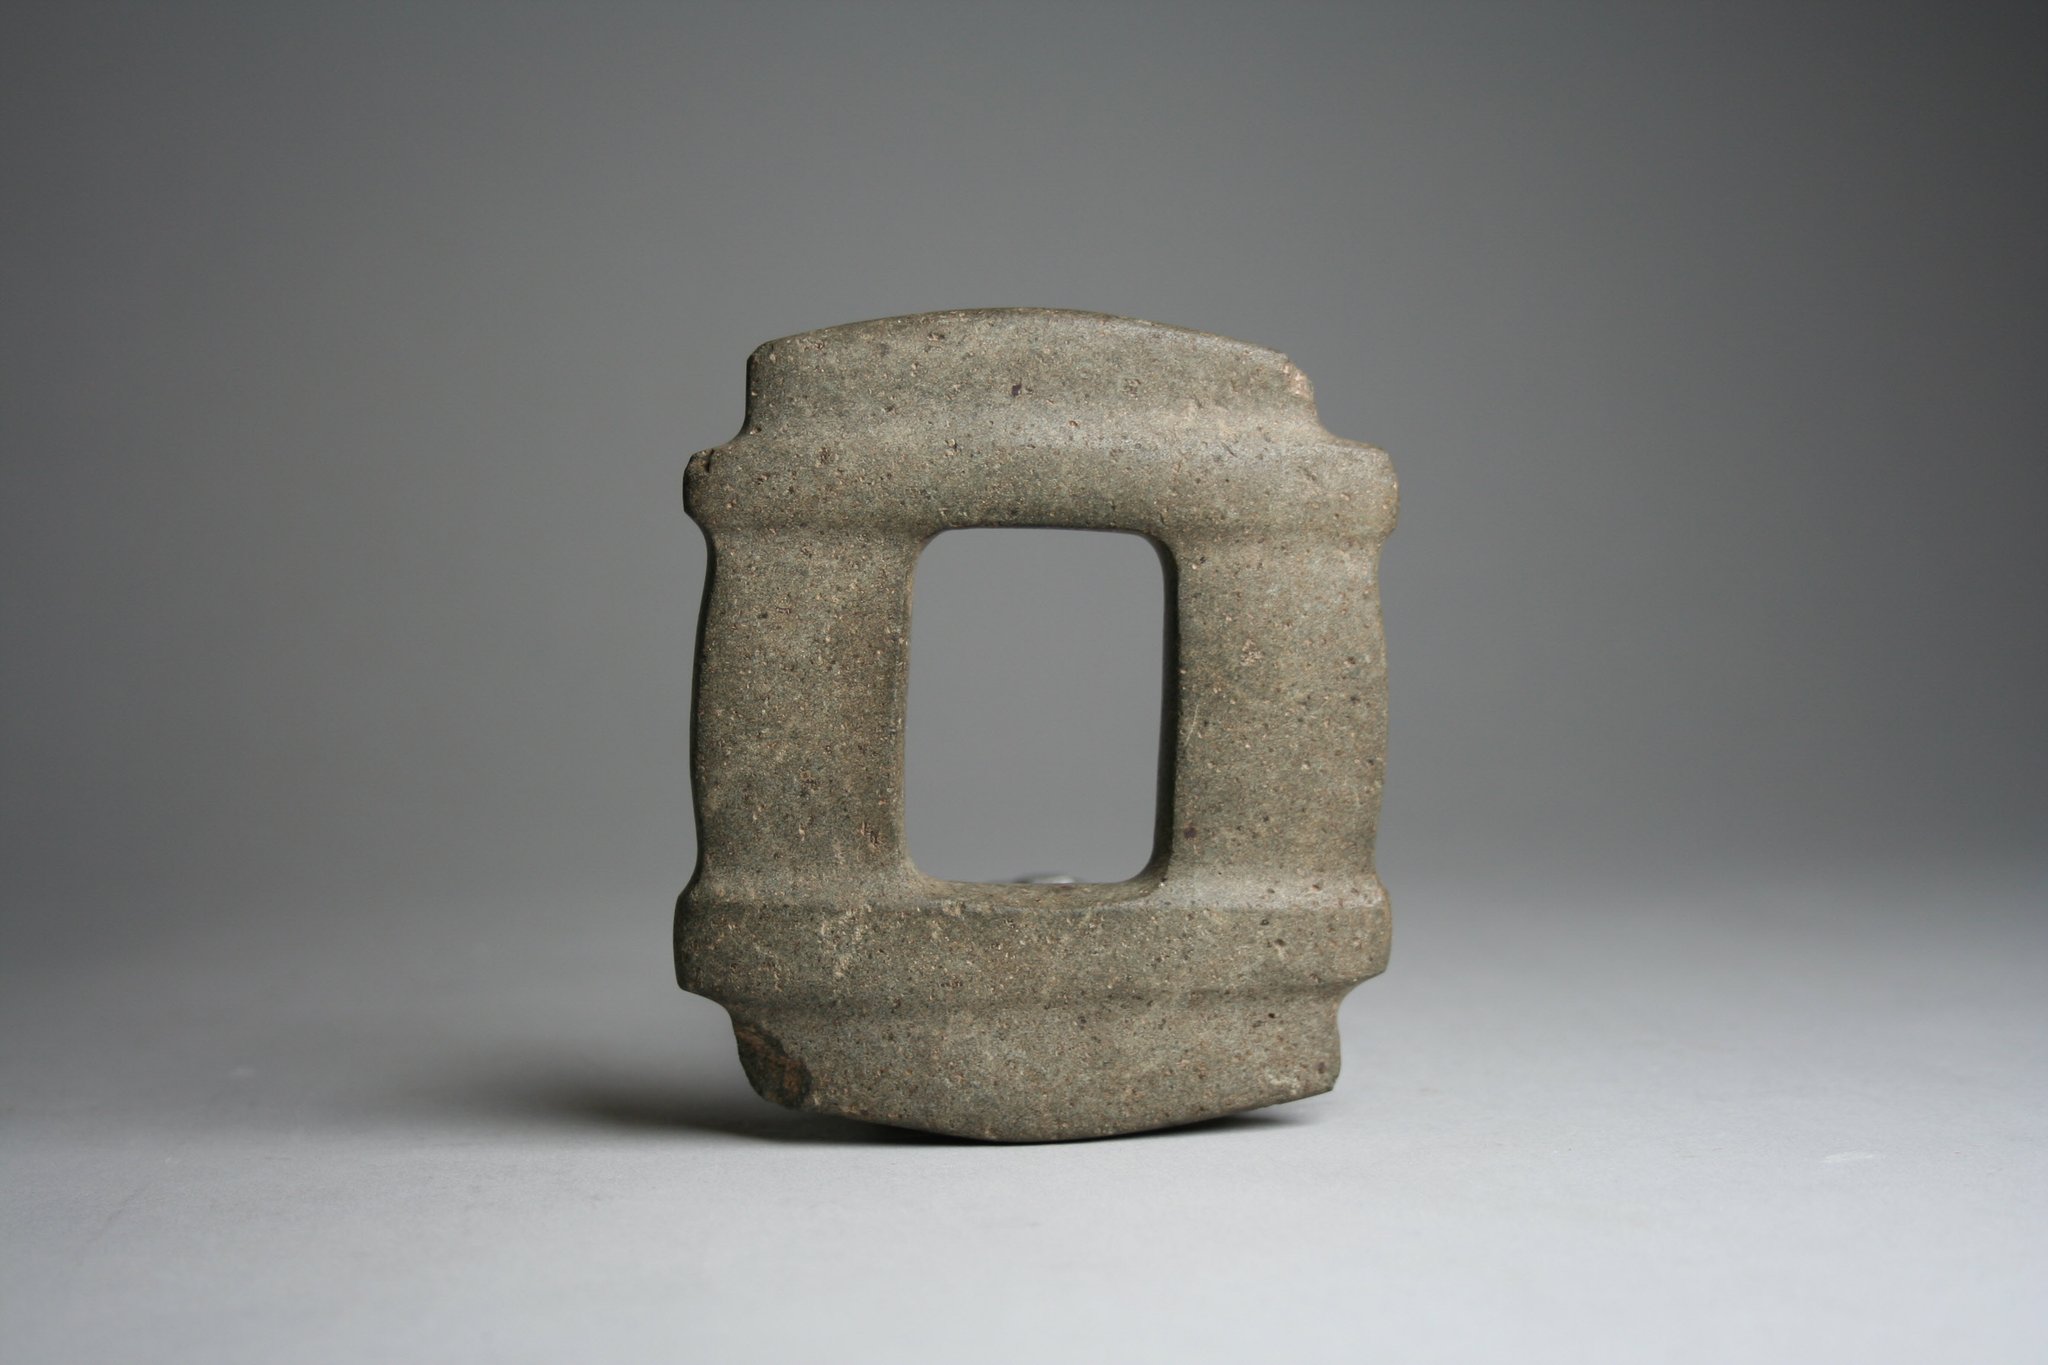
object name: architectural model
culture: mezcala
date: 1-800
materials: stone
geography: mexico